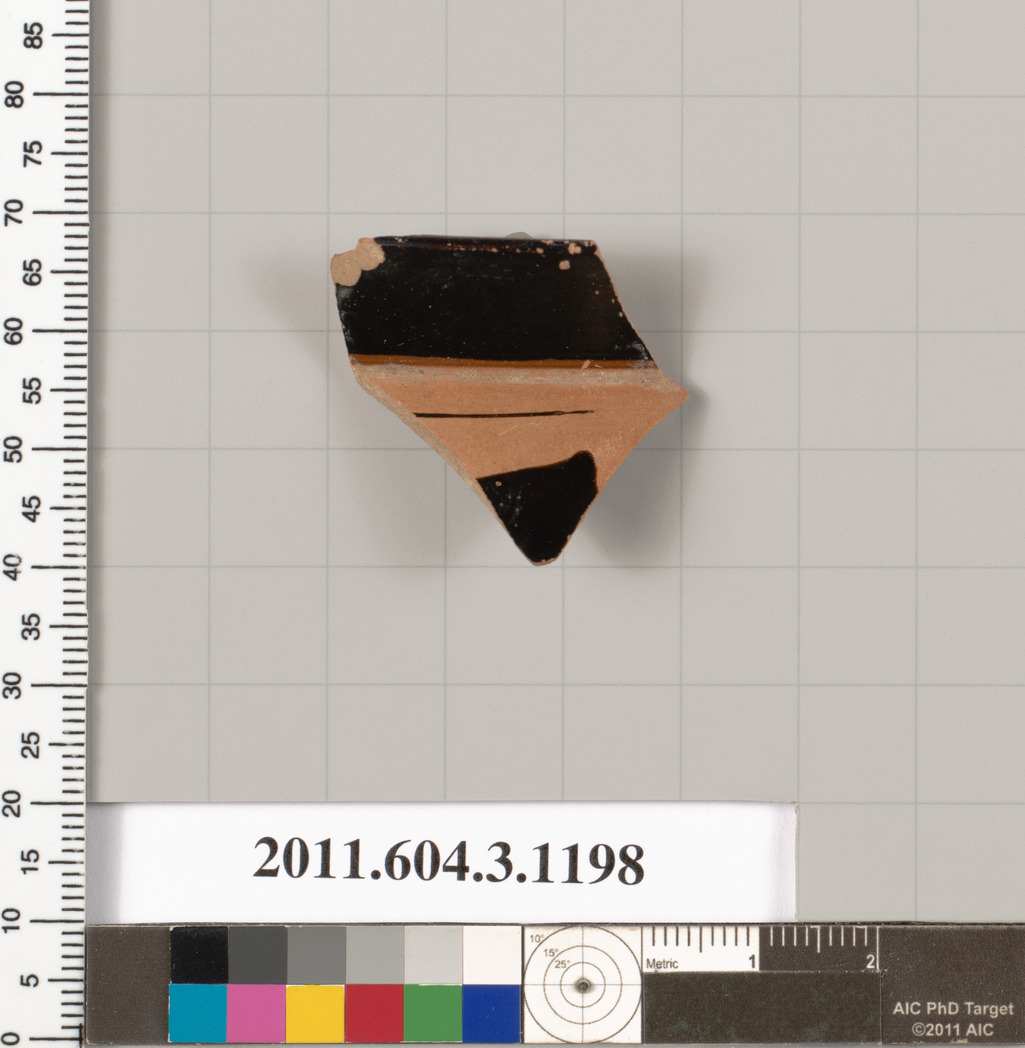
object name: mastoid fragment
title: Terracotta rim fragment of a mastoid (drinking cup with narrow base)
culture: greek, attic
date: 534-468 BCE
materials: terracotta